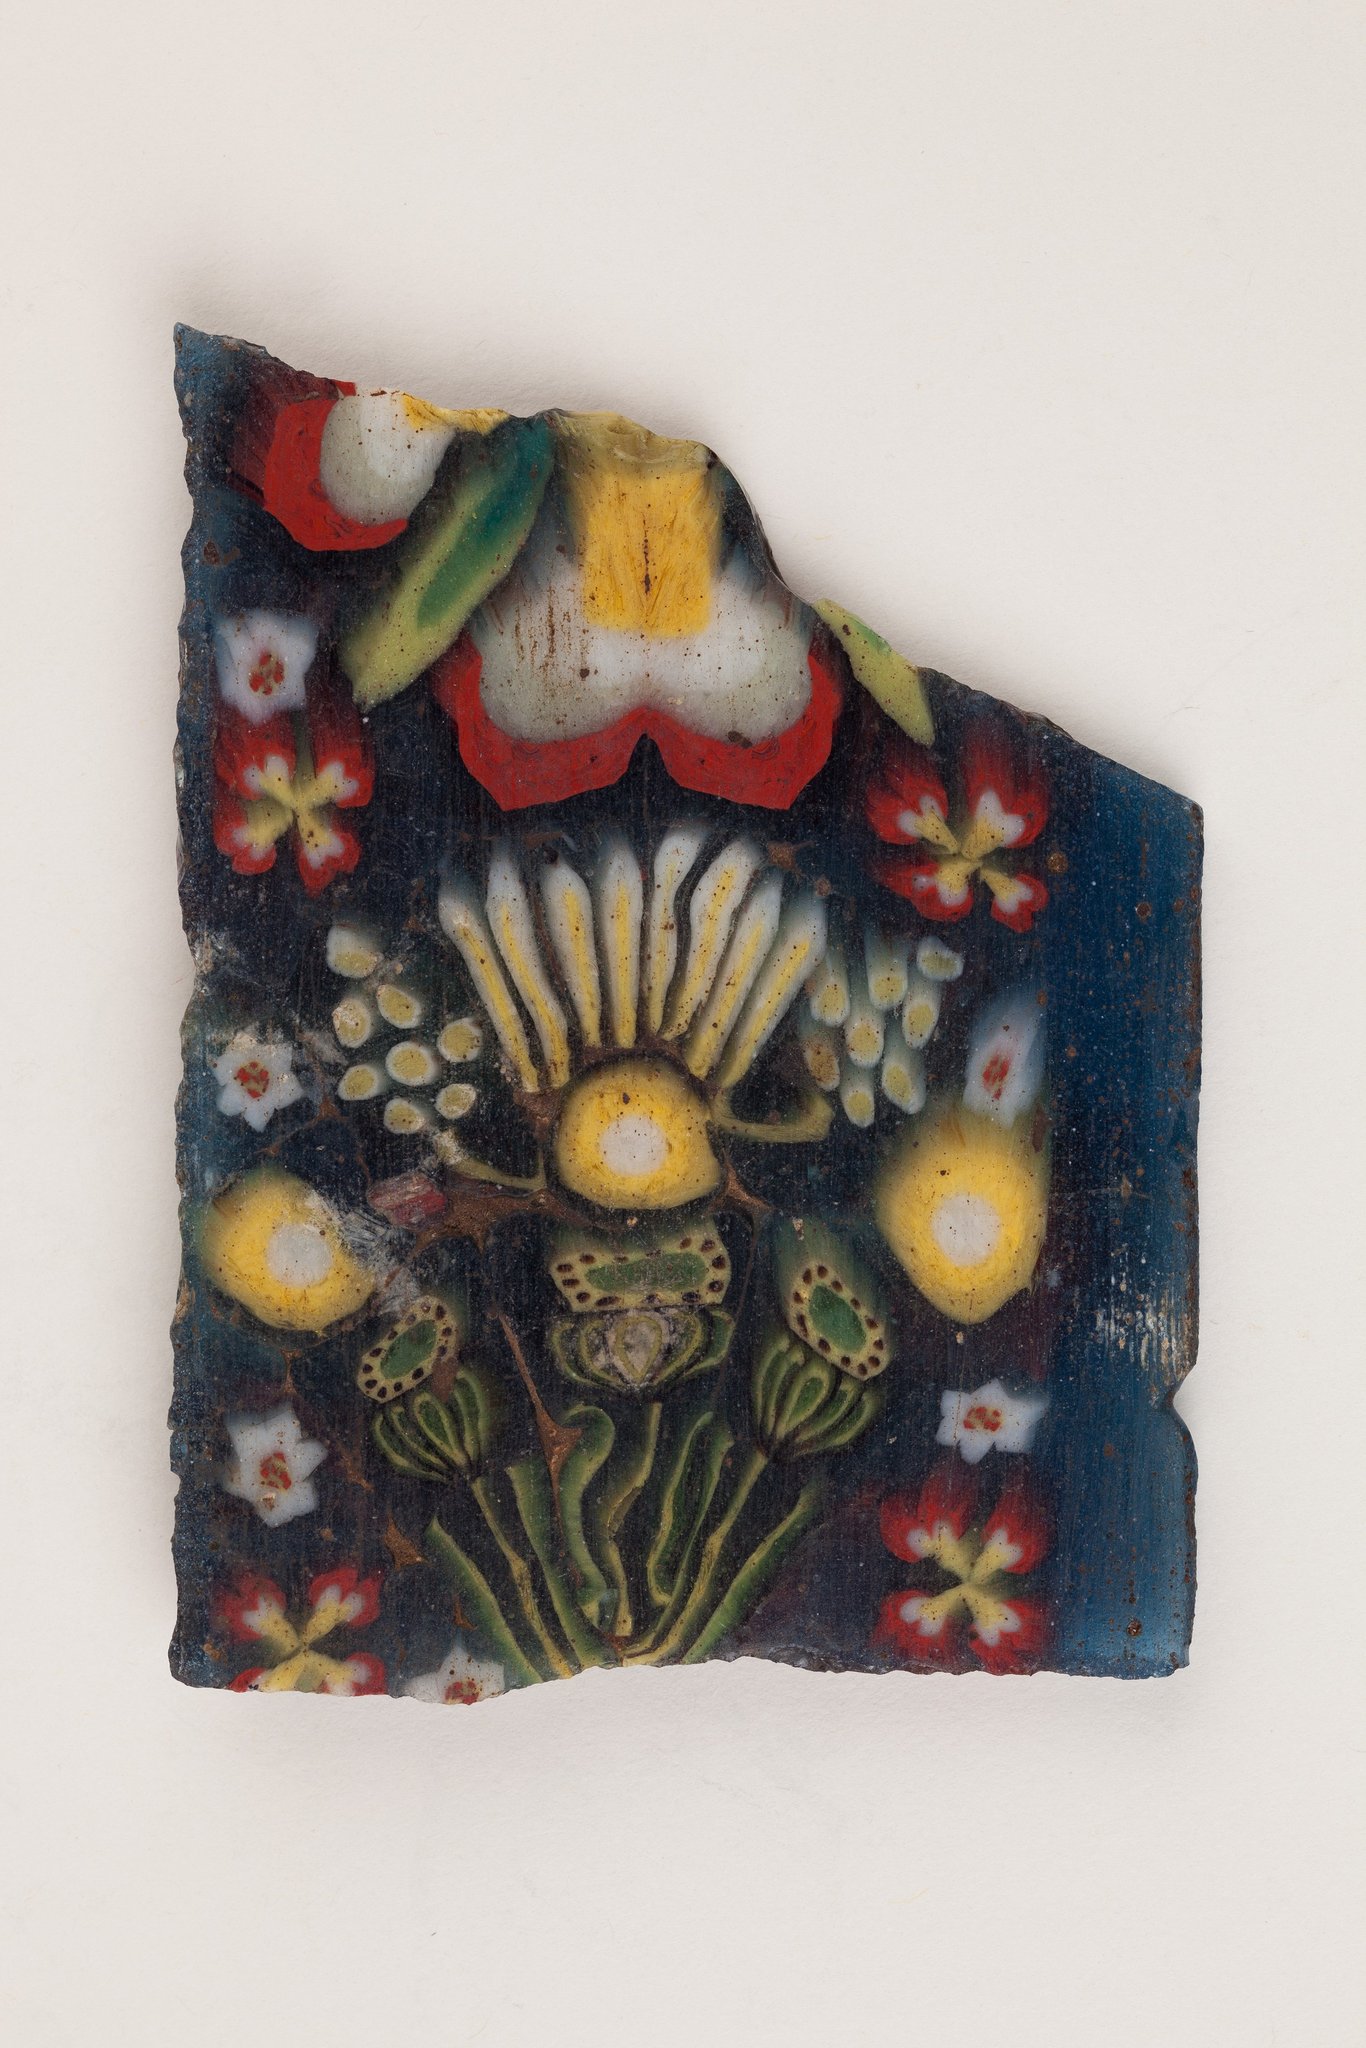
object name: plaque, floral, inlay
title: Floral plaque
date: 100 BCE-100 CE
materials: glass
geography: egypt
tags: flowers